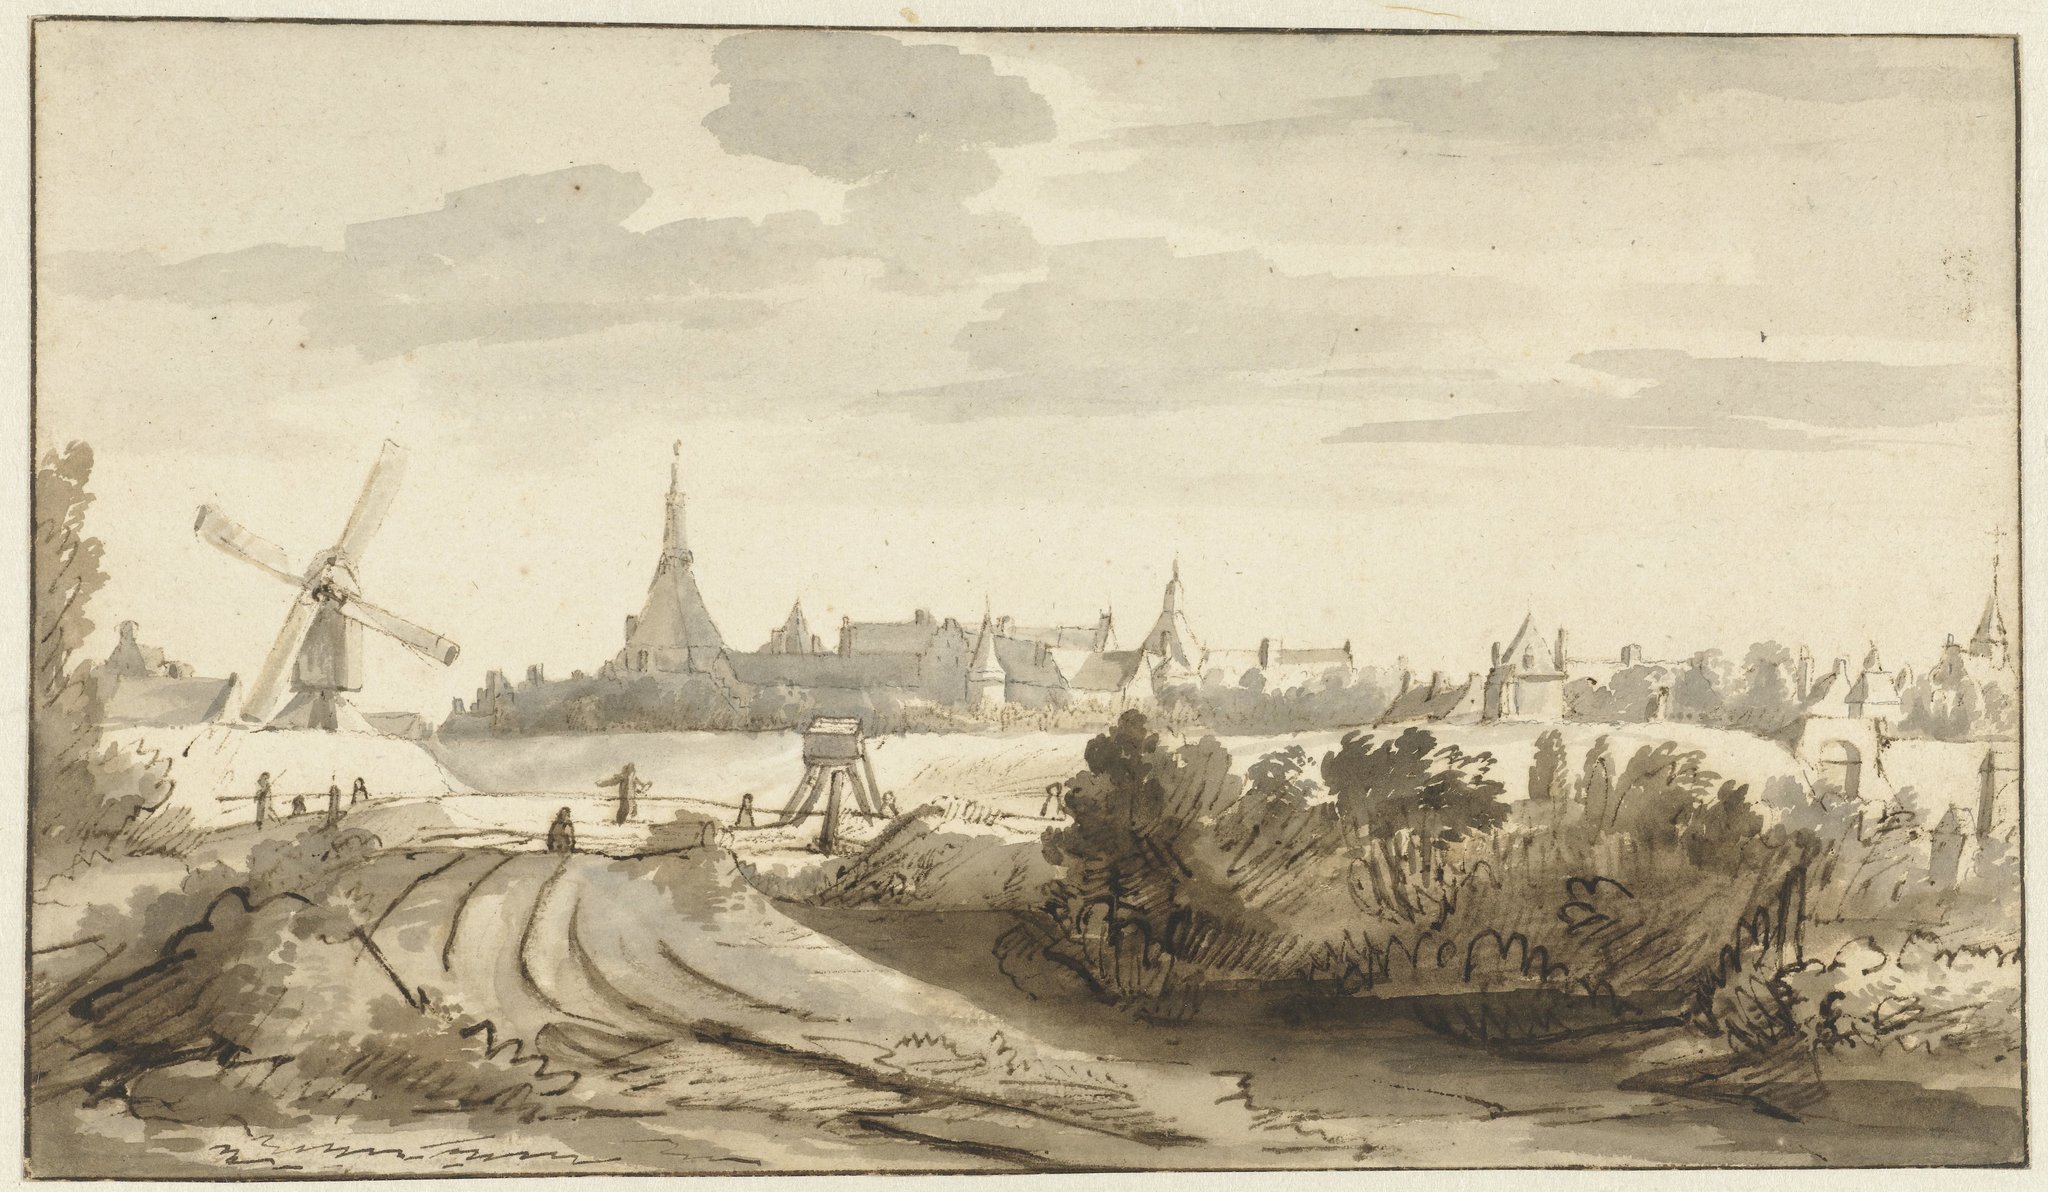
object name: drawing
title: Gezicht op Ravestein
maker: nicolaes maes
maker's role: draughtsman, painter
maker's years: 1634-1693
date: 1653-1659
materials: ink, paper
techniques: brush, pen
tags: prospect of city, town panorama, silhouette of city